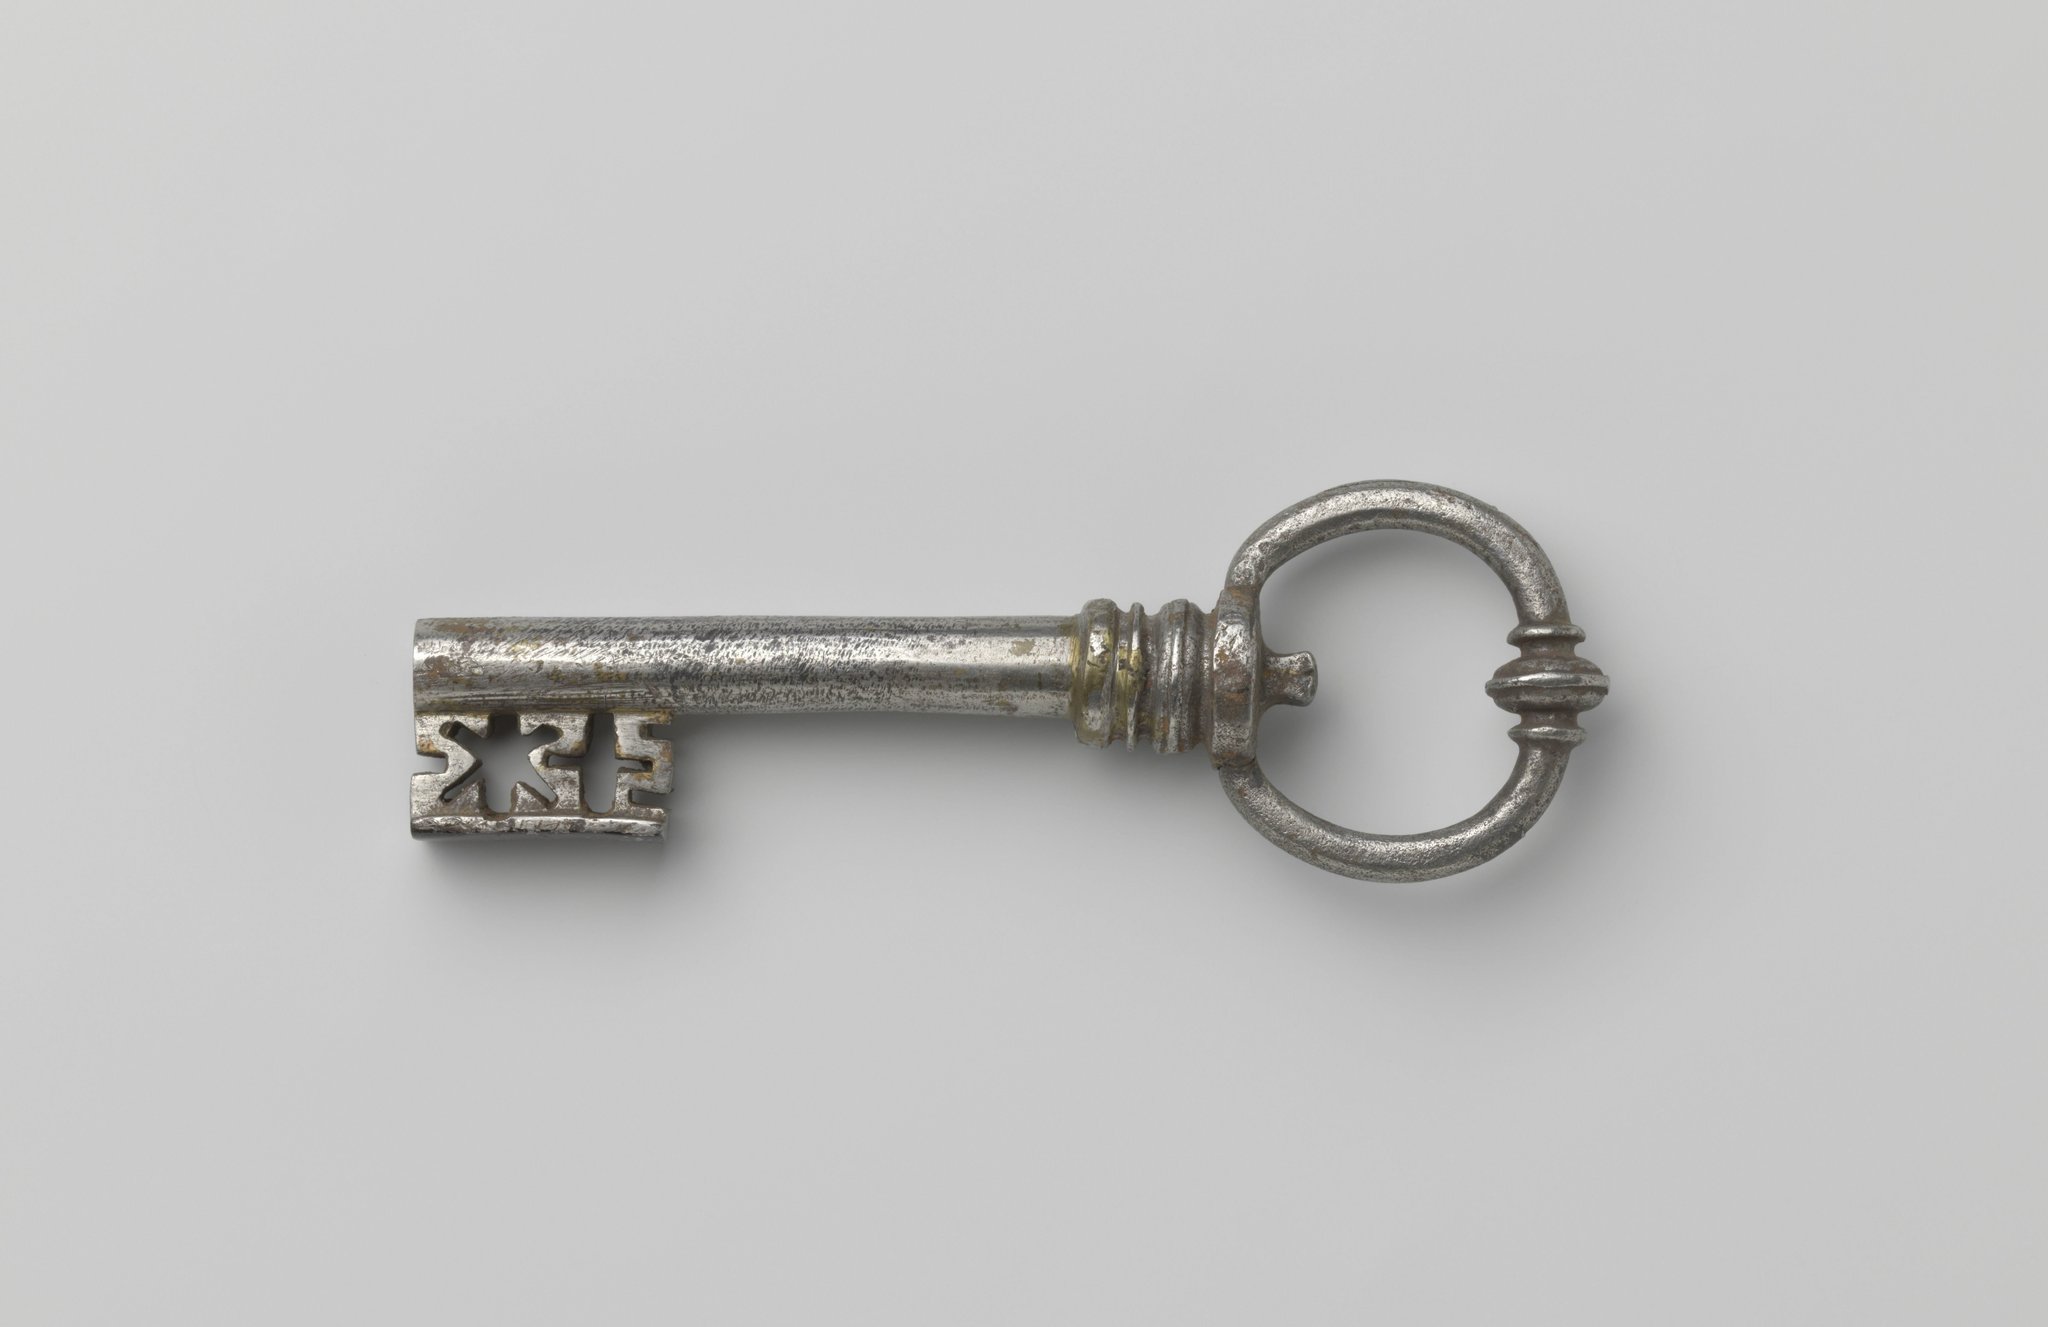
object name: pipe key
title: Pijpsleutel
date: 1600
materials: iron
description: Pijpsleutel waarvan het ringvormig oog bovenaan door een schijf tussen twee kleine schijven doorbroken wordt. Op het geprofileerd rond kapiteel bevindt zich een vierkant opstandje. De baard heeft een kruis- en stervormige bezetting.